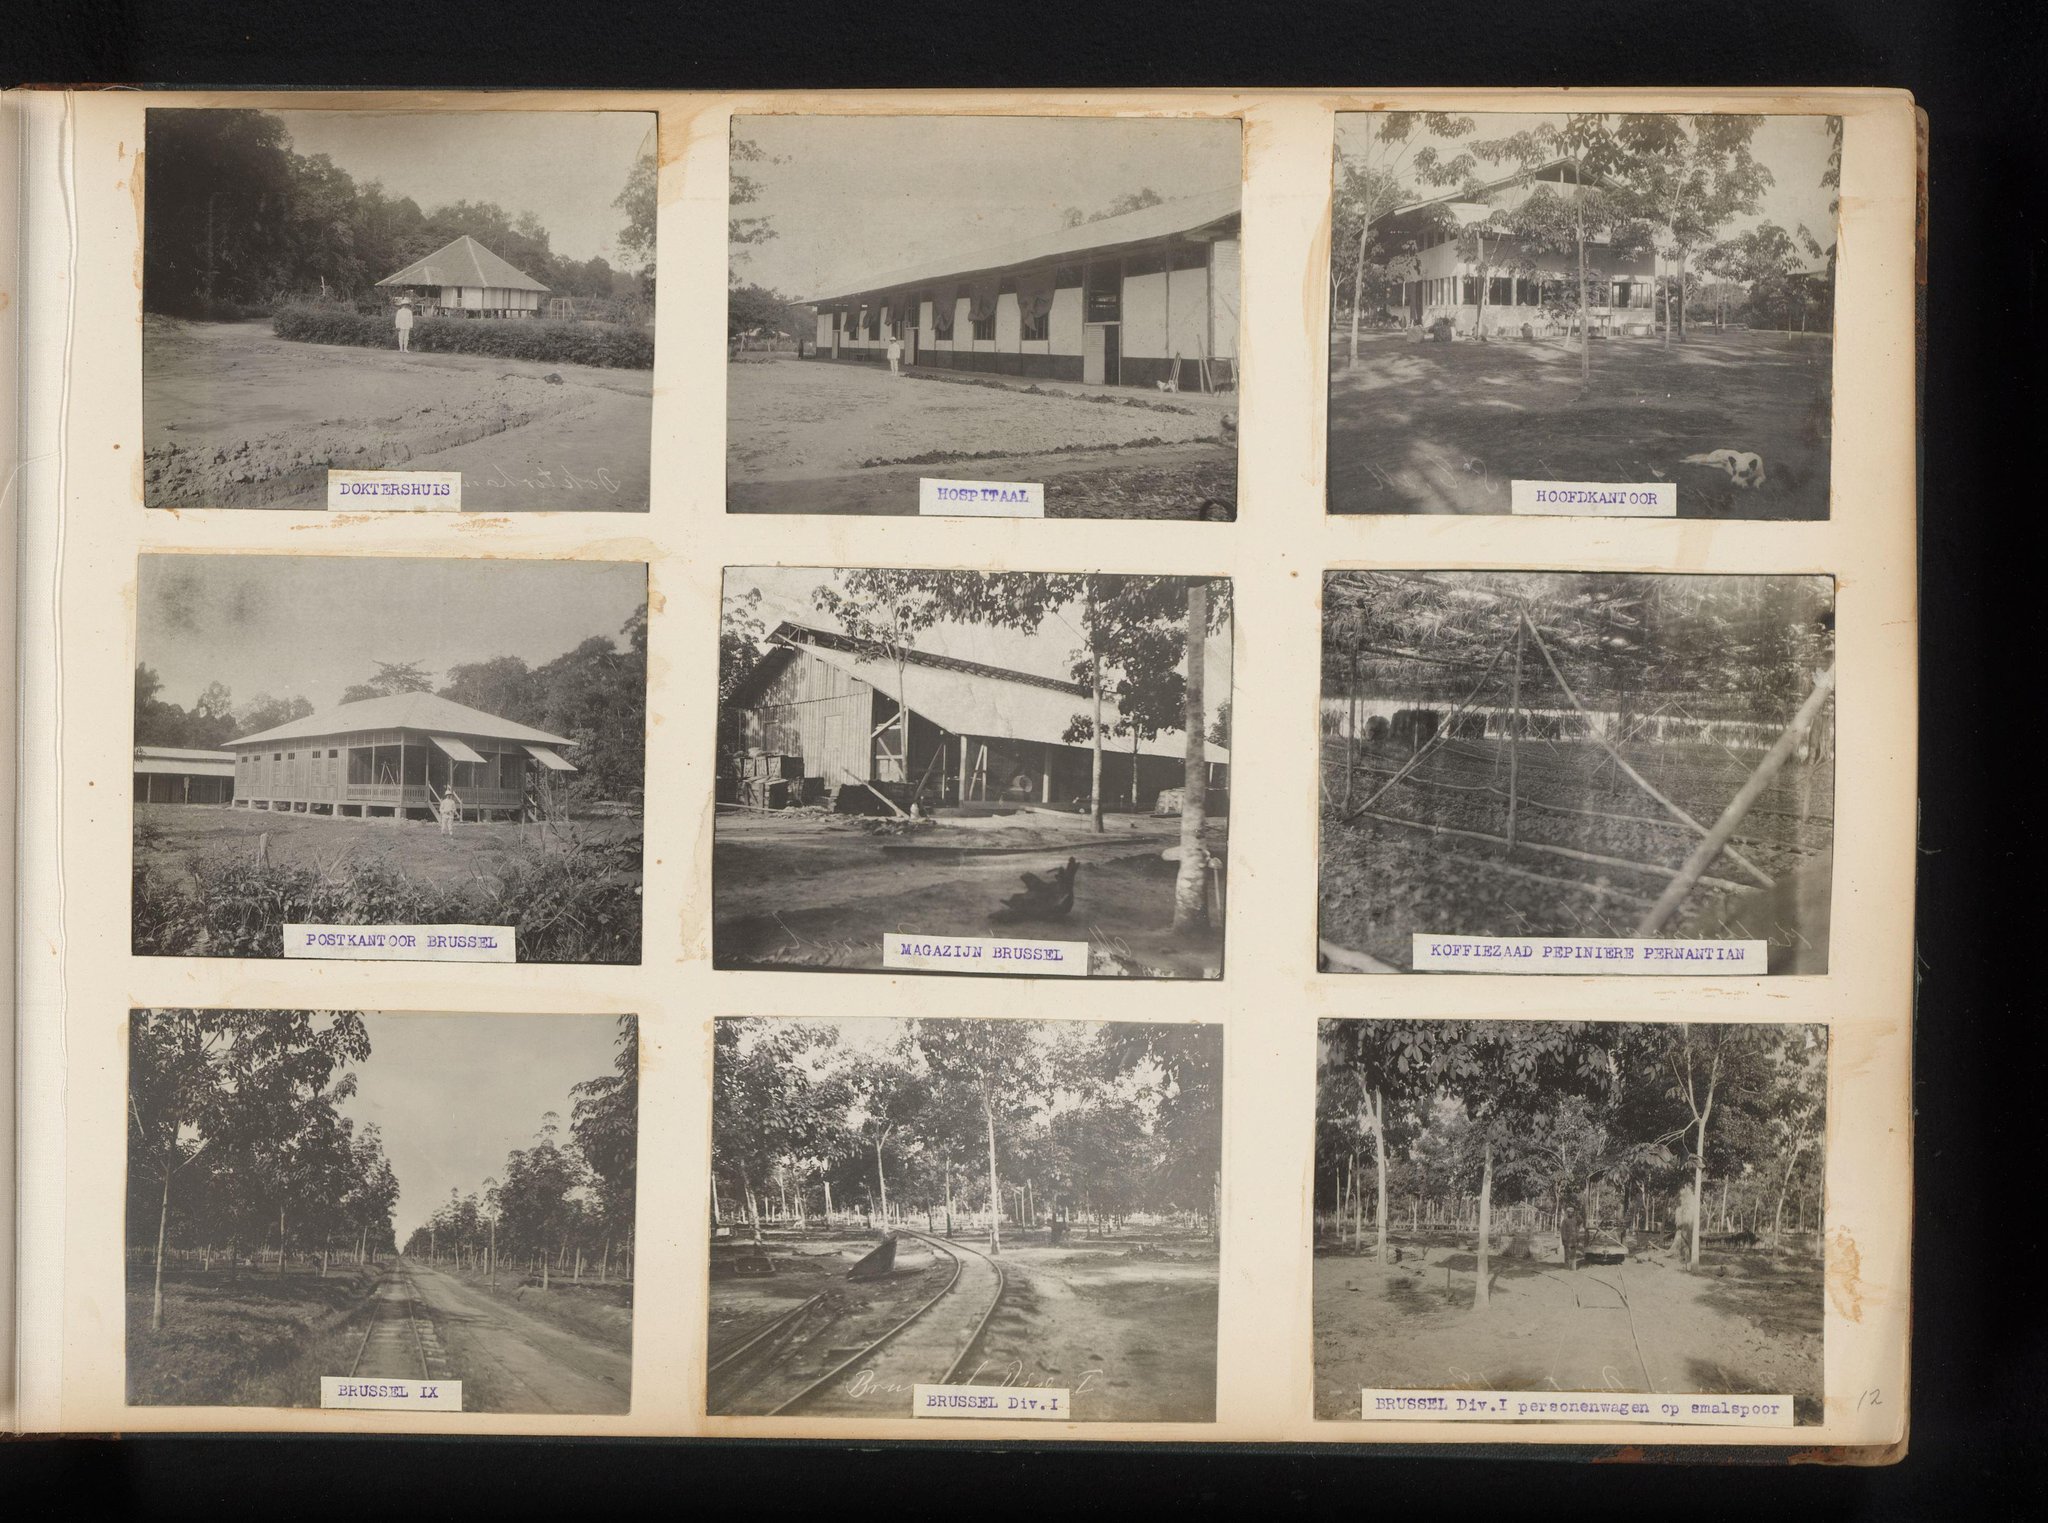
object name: album leaf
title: Gebouwen en koffieplantjes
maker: Anonymous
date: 1910-1913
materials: cardboard, photographic support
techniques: gelatin silver print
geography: east sumatra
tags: plantation, (non-fruit) products of plants or trees: rubber, fruits: coffee, railway, tramway; rack railway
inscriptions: inscription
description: Blad met negen foto's van gebouwen en spoorlijn op de plantage Brussel en van jonge koffieplanten in de kwekerij op Pernantian. Onder de foto's etiketten met onderschriften. Onderdeel van het fotoalbum over de plantages Brussel en Pernantian van de Sumatra Caoutchouc Maatschappij op de Oostkust van Sumatra in de jaren 1910-1935.